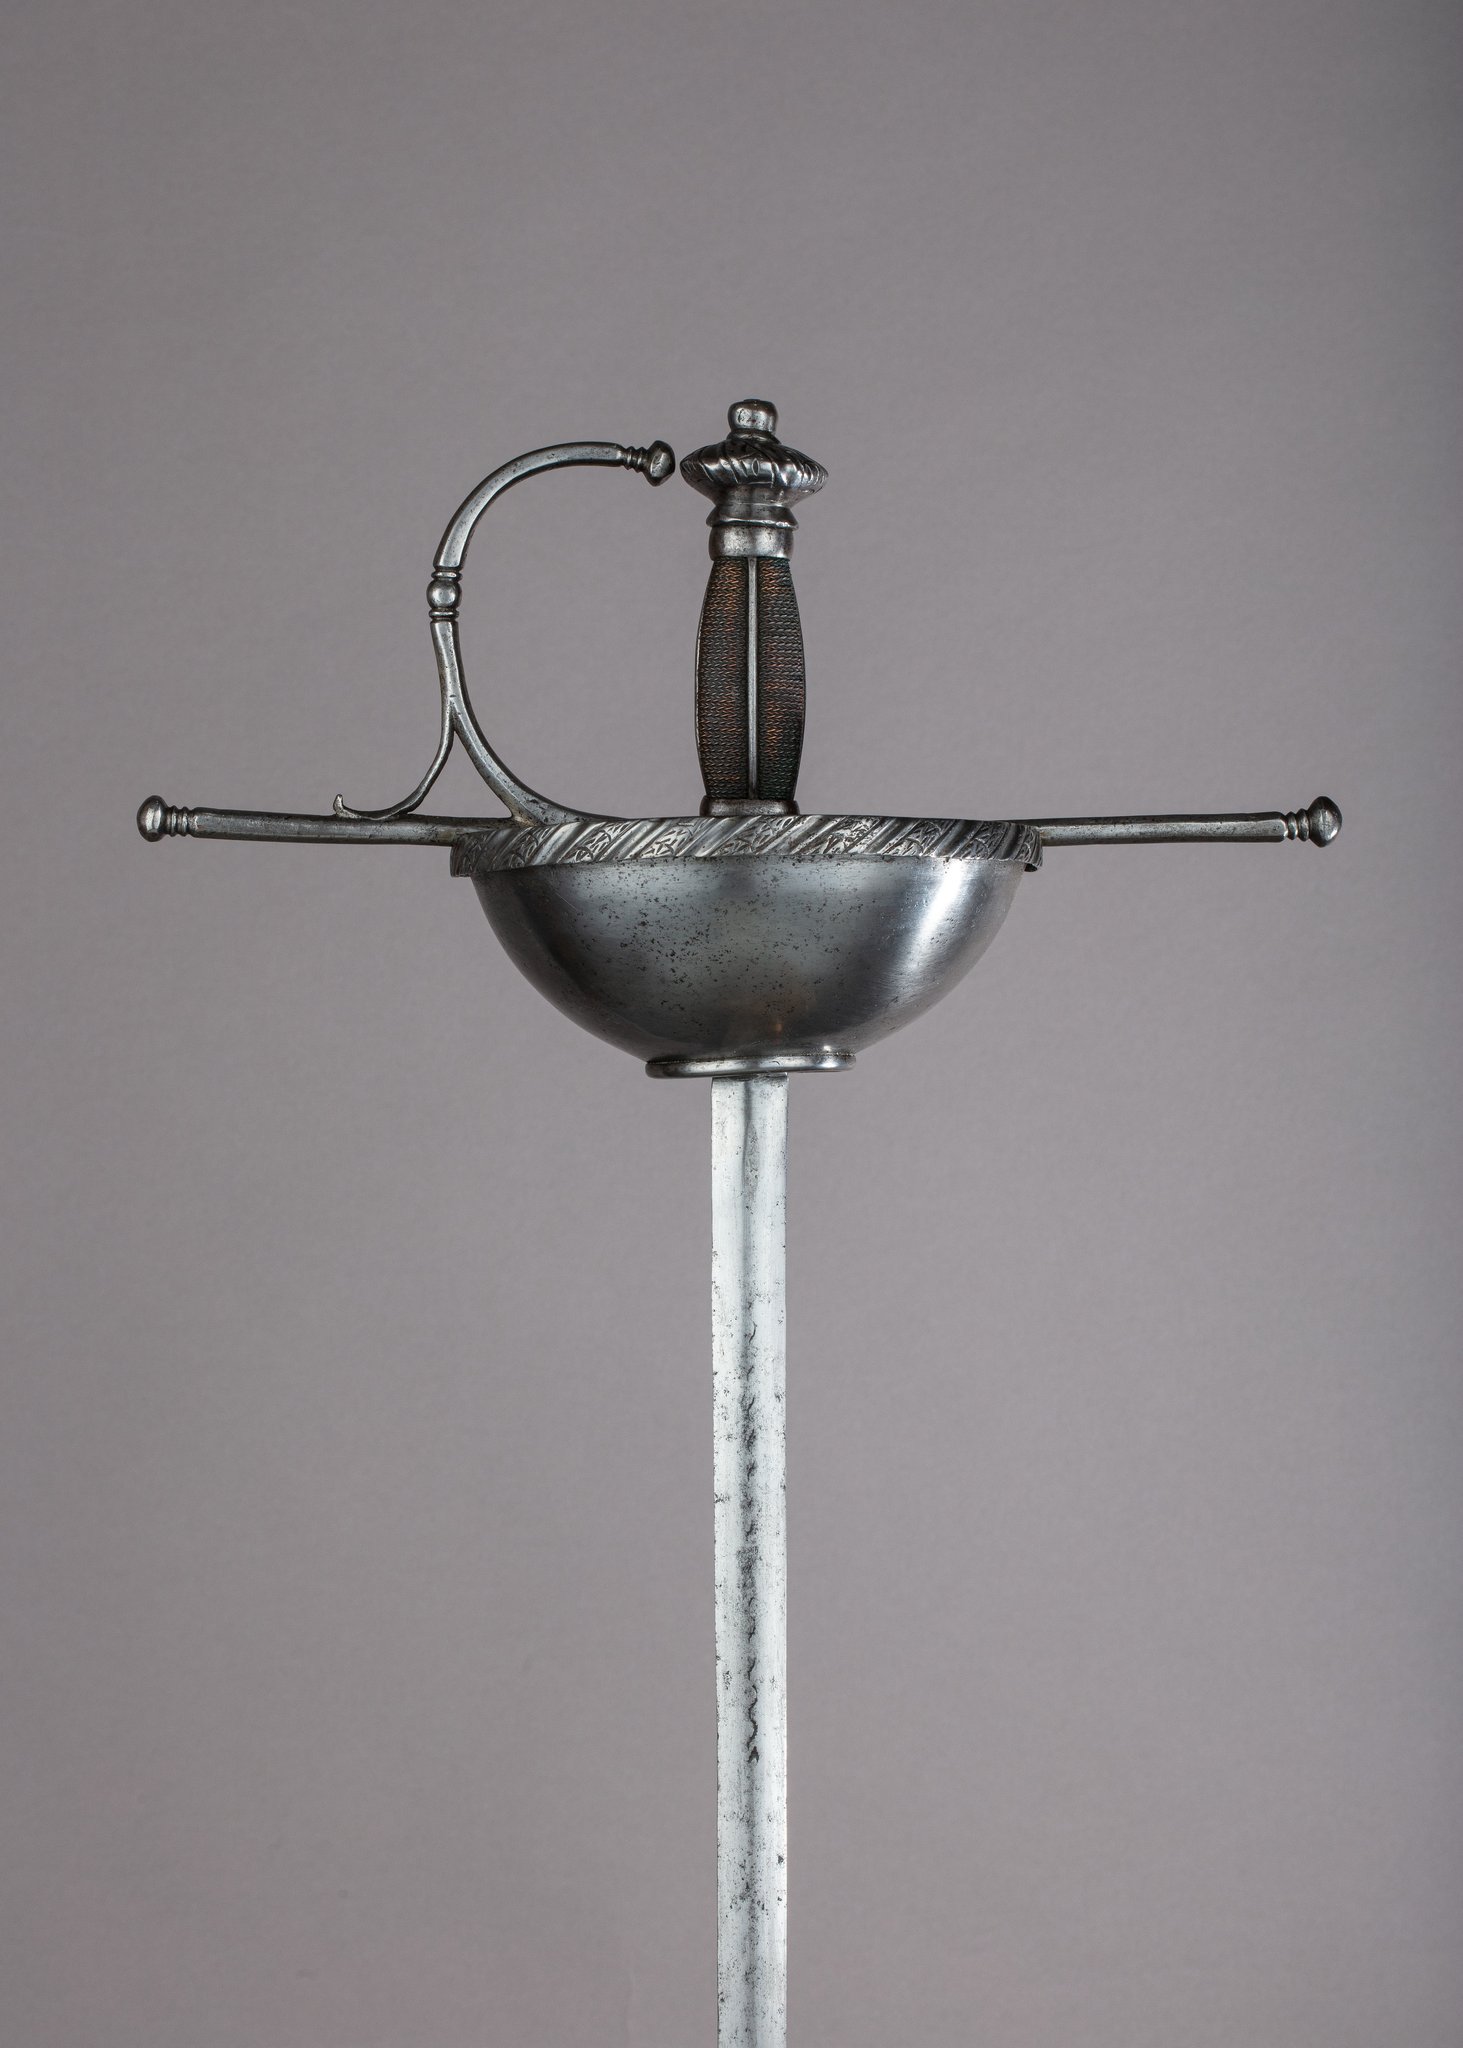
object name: cup hilted rapier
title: Cup-Hilted Rapier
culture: spanish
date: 1601-1700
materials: copper, steel, metal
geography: spain